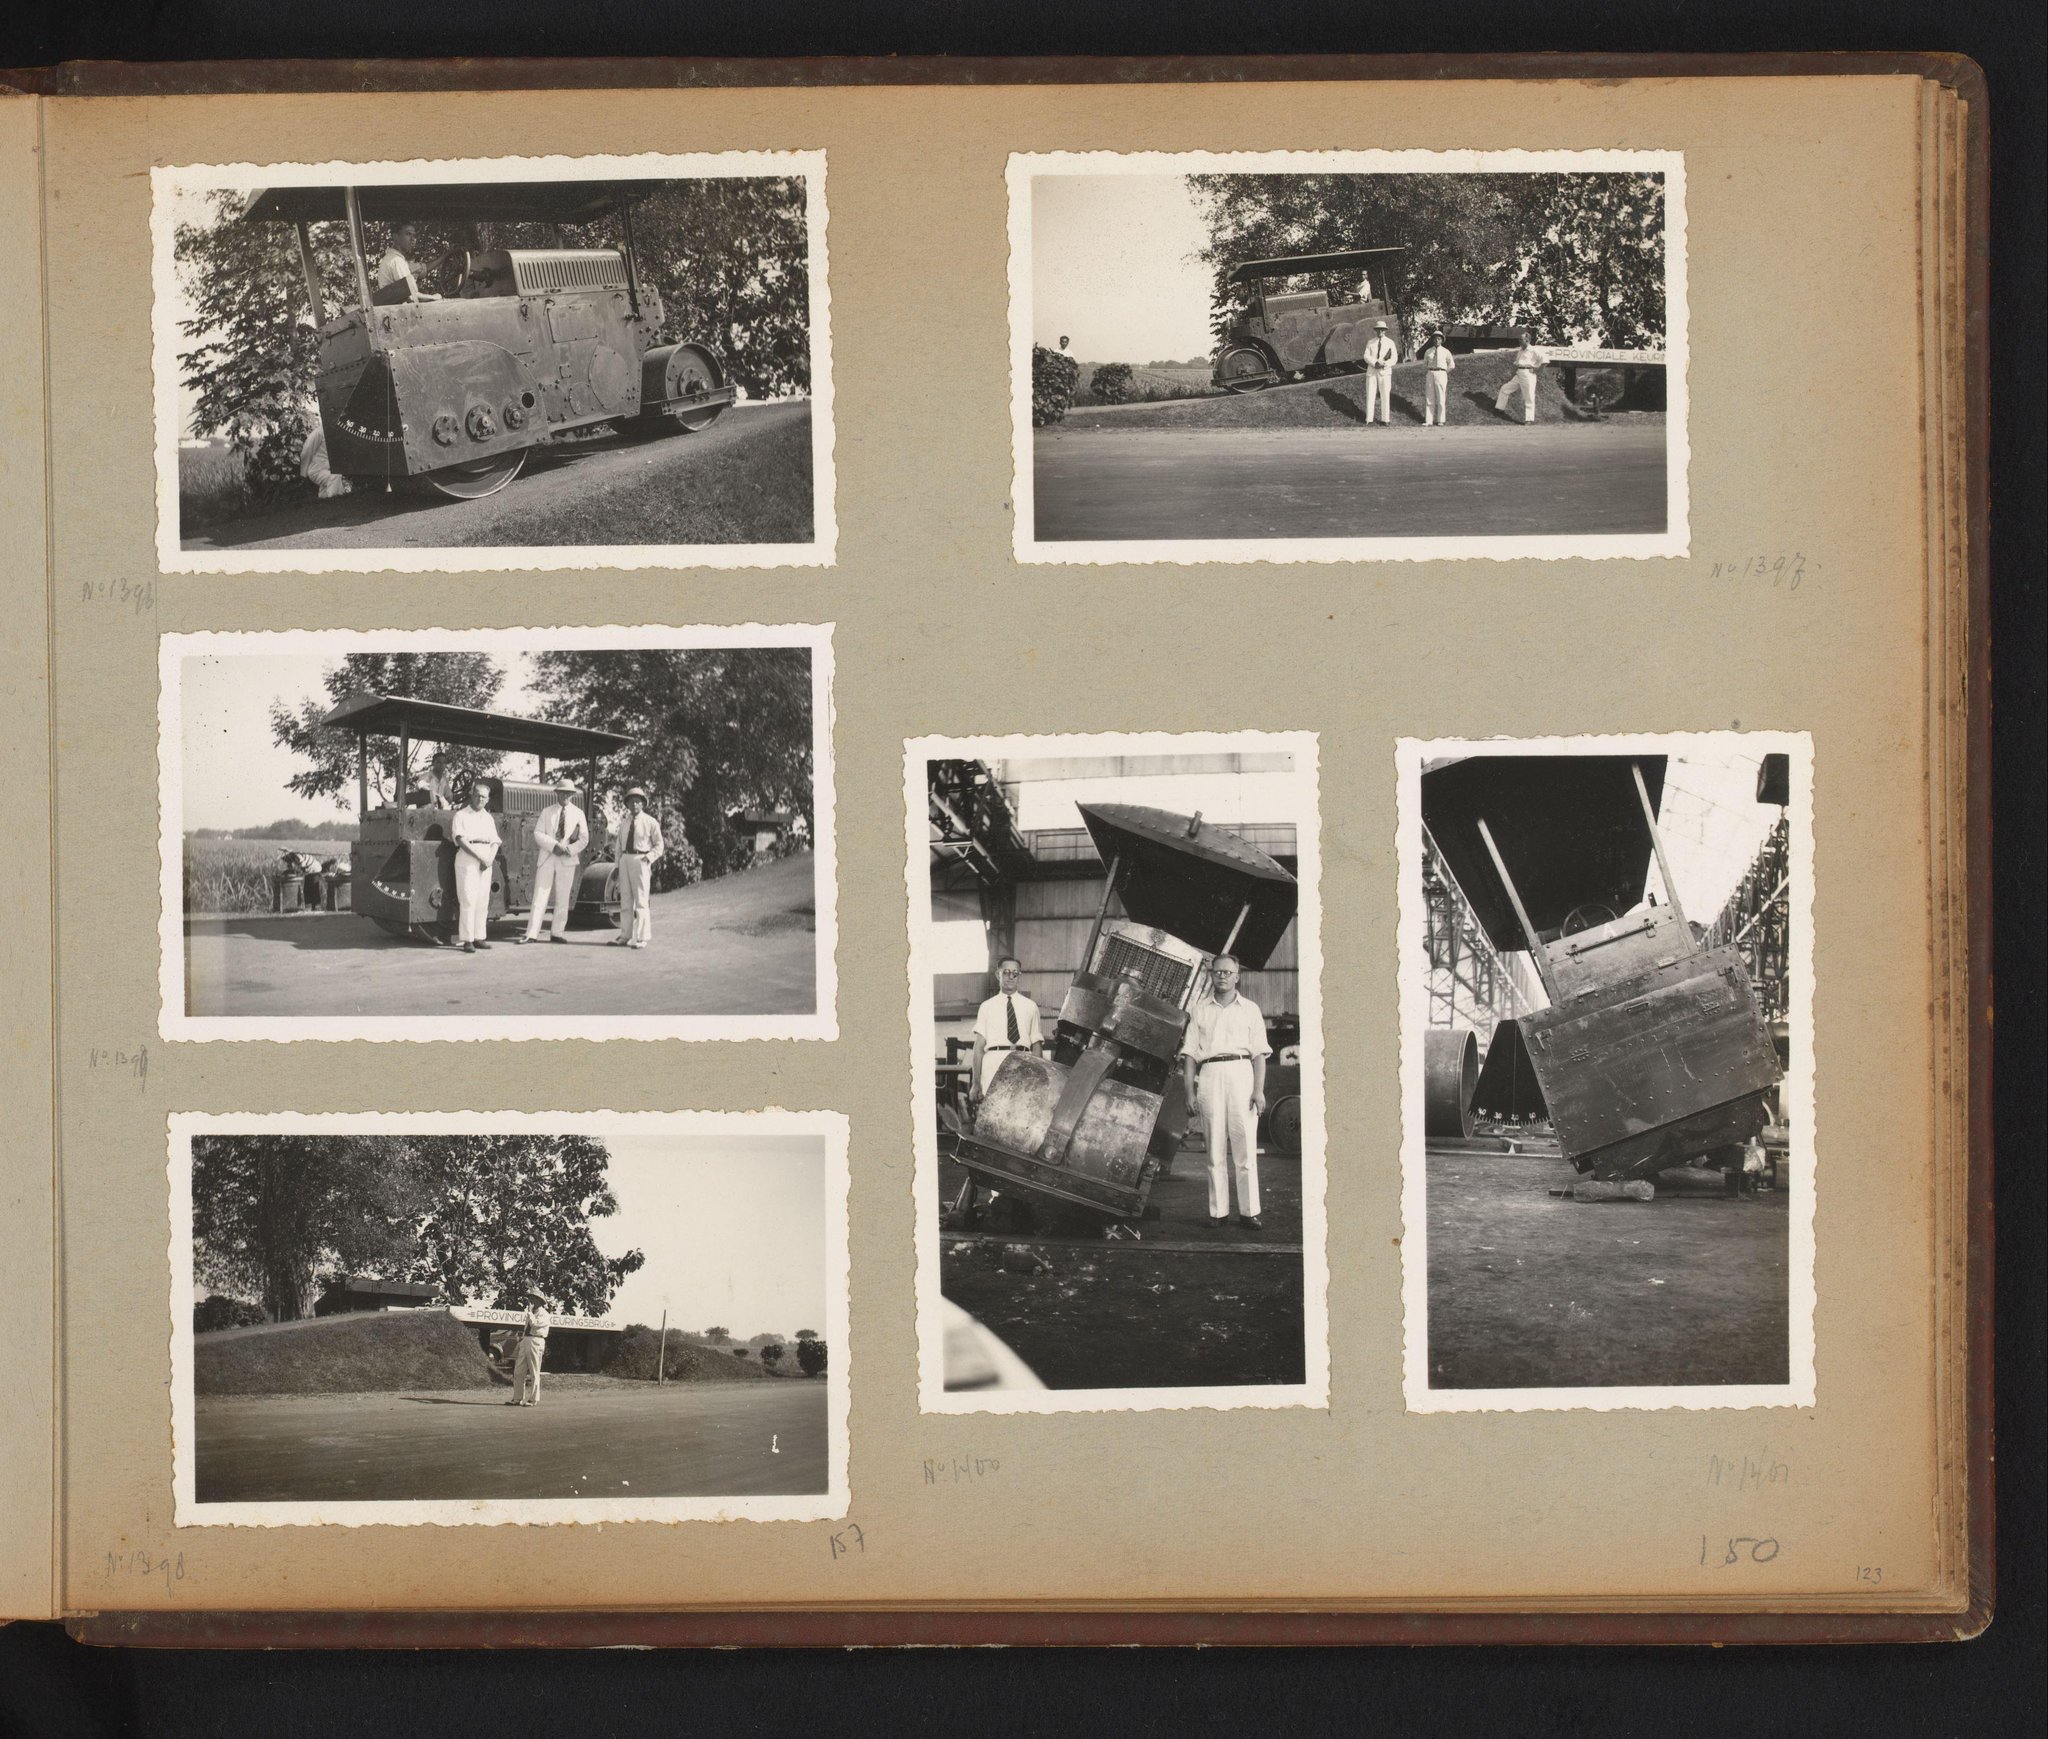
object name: photograph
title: Testen van een wals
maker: Anonymous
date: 1931-1937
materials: cardboard, photographic support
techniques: gelatin silver print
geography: java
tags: other motor-vehicles not meant or mentioned above, java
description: Albumblad met zes foto's van het testen van een wals. Onderdeel van een fotoalbum met foto's van machines en constructies van de N.V. Machinefabriek Braat te Soerabaja, Soekaboemi en Tegal uit de periode 1931-1937.